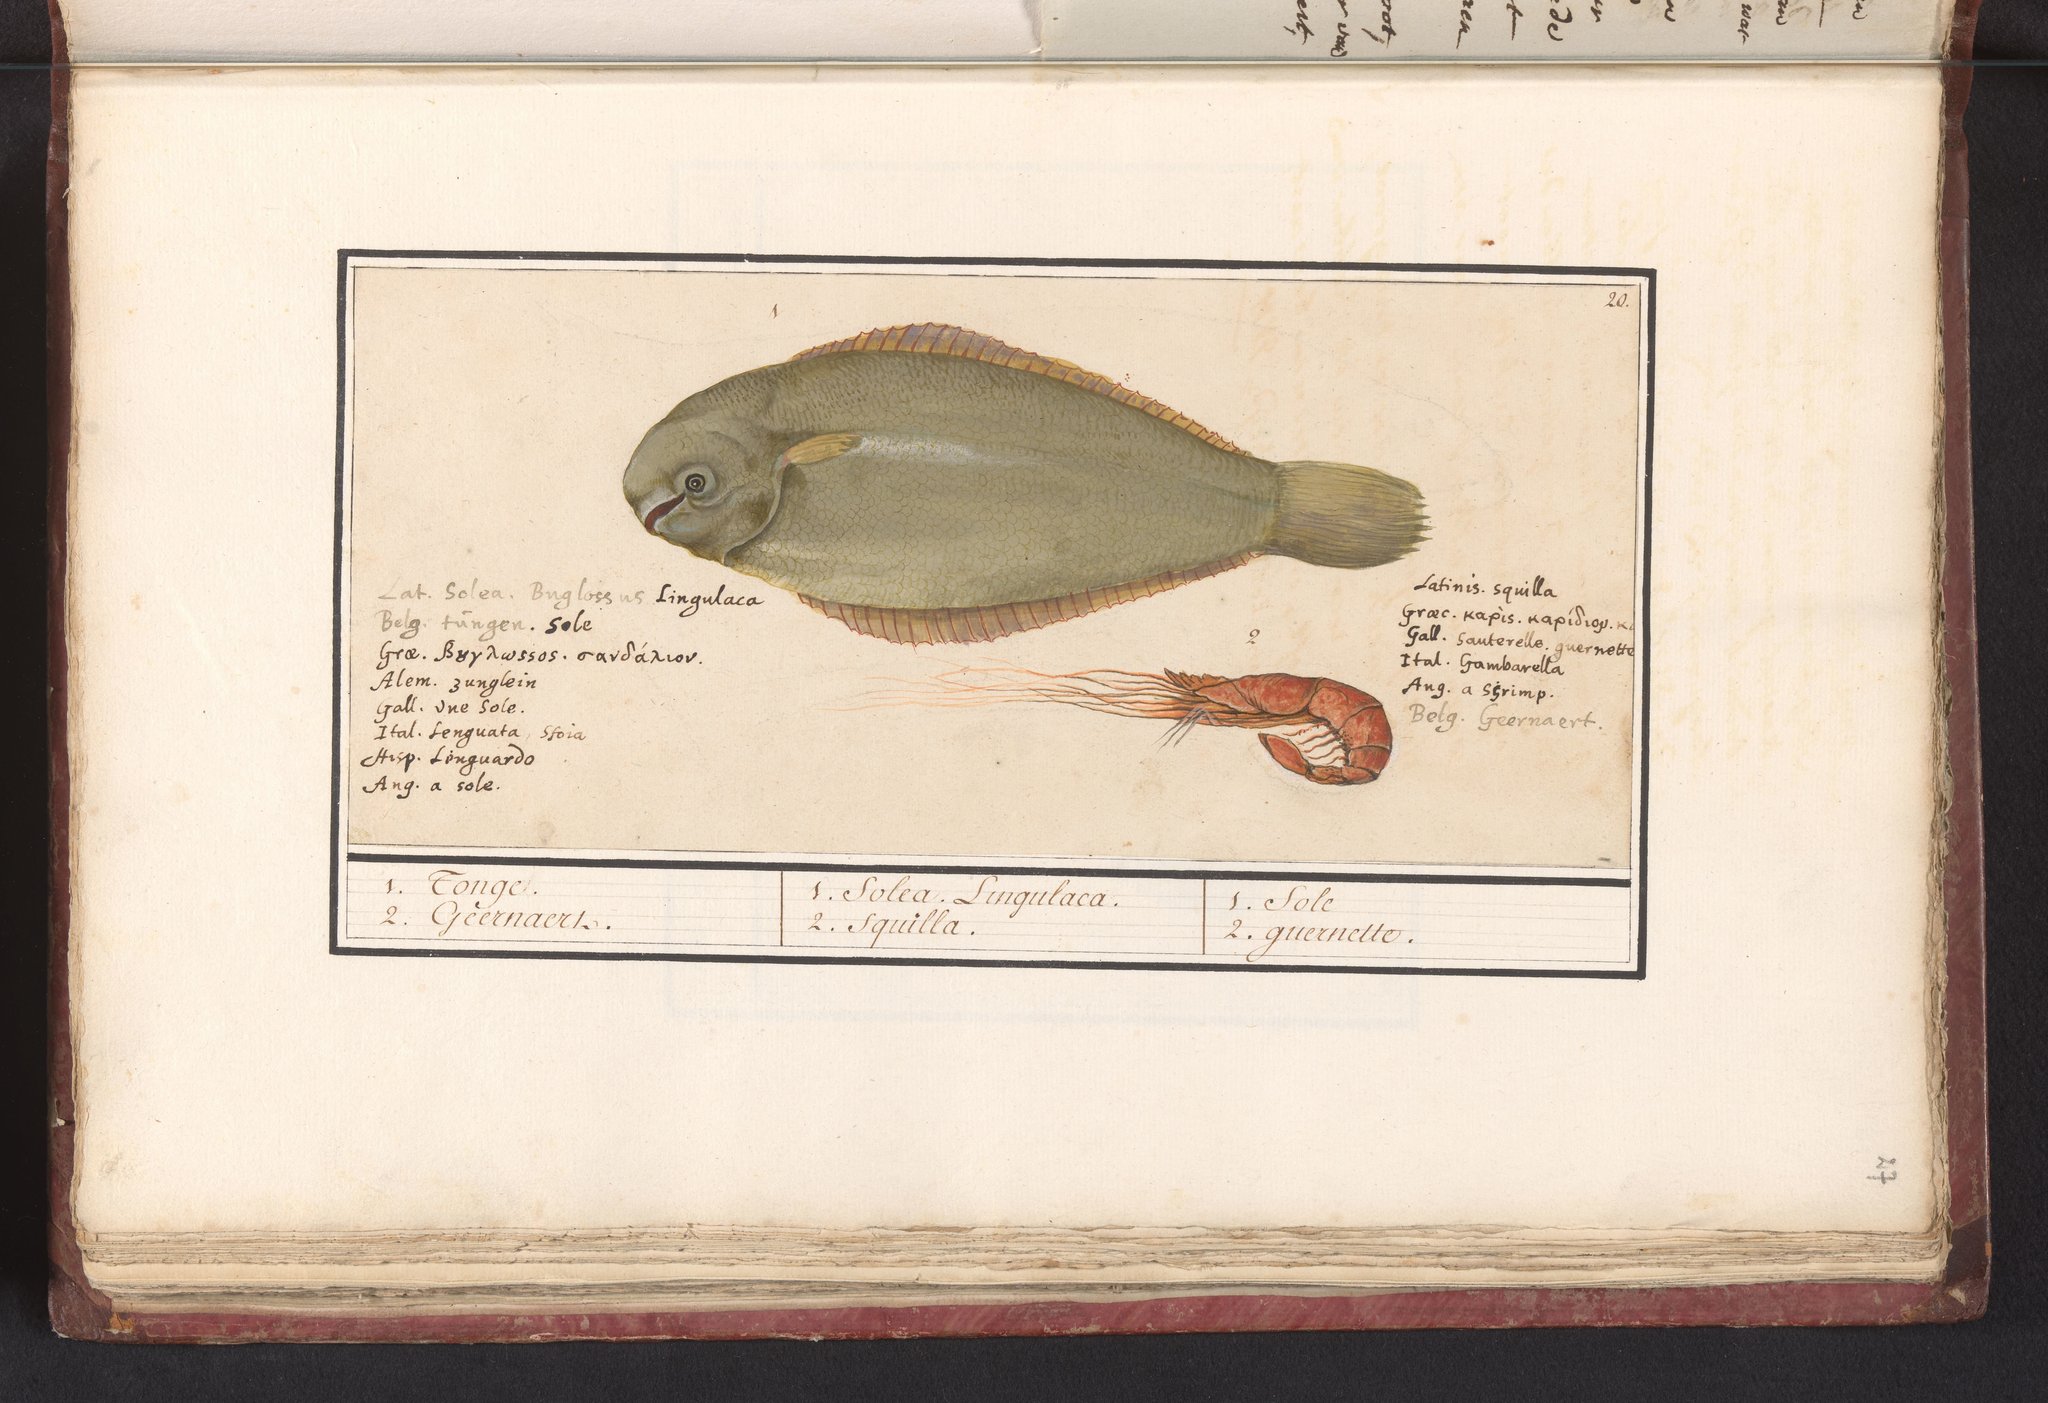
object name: drawing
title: Tong (Solea solea) en roze garnaal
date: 1596-1610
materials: chalk, paint, ink, paper, pencil, watercolor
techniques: brush, pen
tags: crustaceans: shrimp, bony fishes: sole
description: Tong en roze garnaal. Genummerd rechtsboven: 20. Rechts de naam van de garnaal in zes talen, links de naam van de tong in acht talen. Onderdeel van het zesde album met tekeningen van vissen, schelpen en insekten. Zesde van twaalf albums met tekeningen van dieren, vogels en planten bekend rond 1600, gemaakt in opdracht van keizer Rudolf II. Met toelichting in Nederlands, Latijn en Frans.